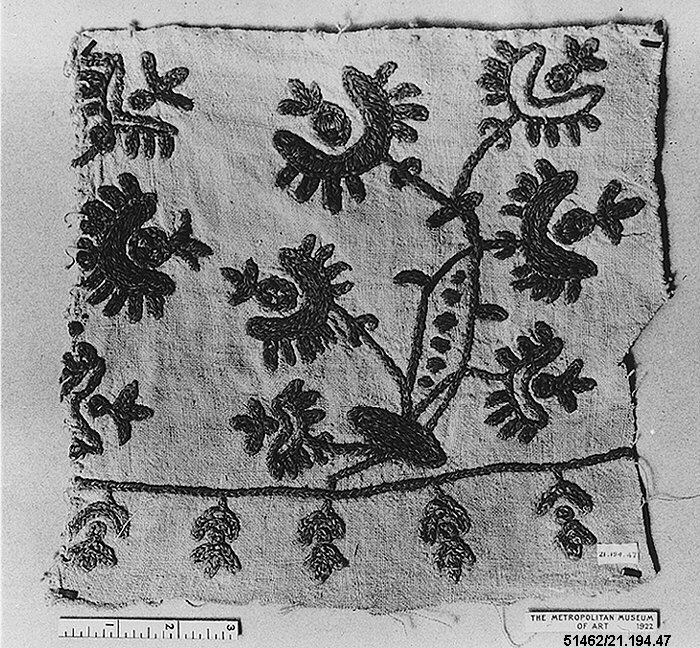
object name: fragment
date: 1767-1800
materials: cotton